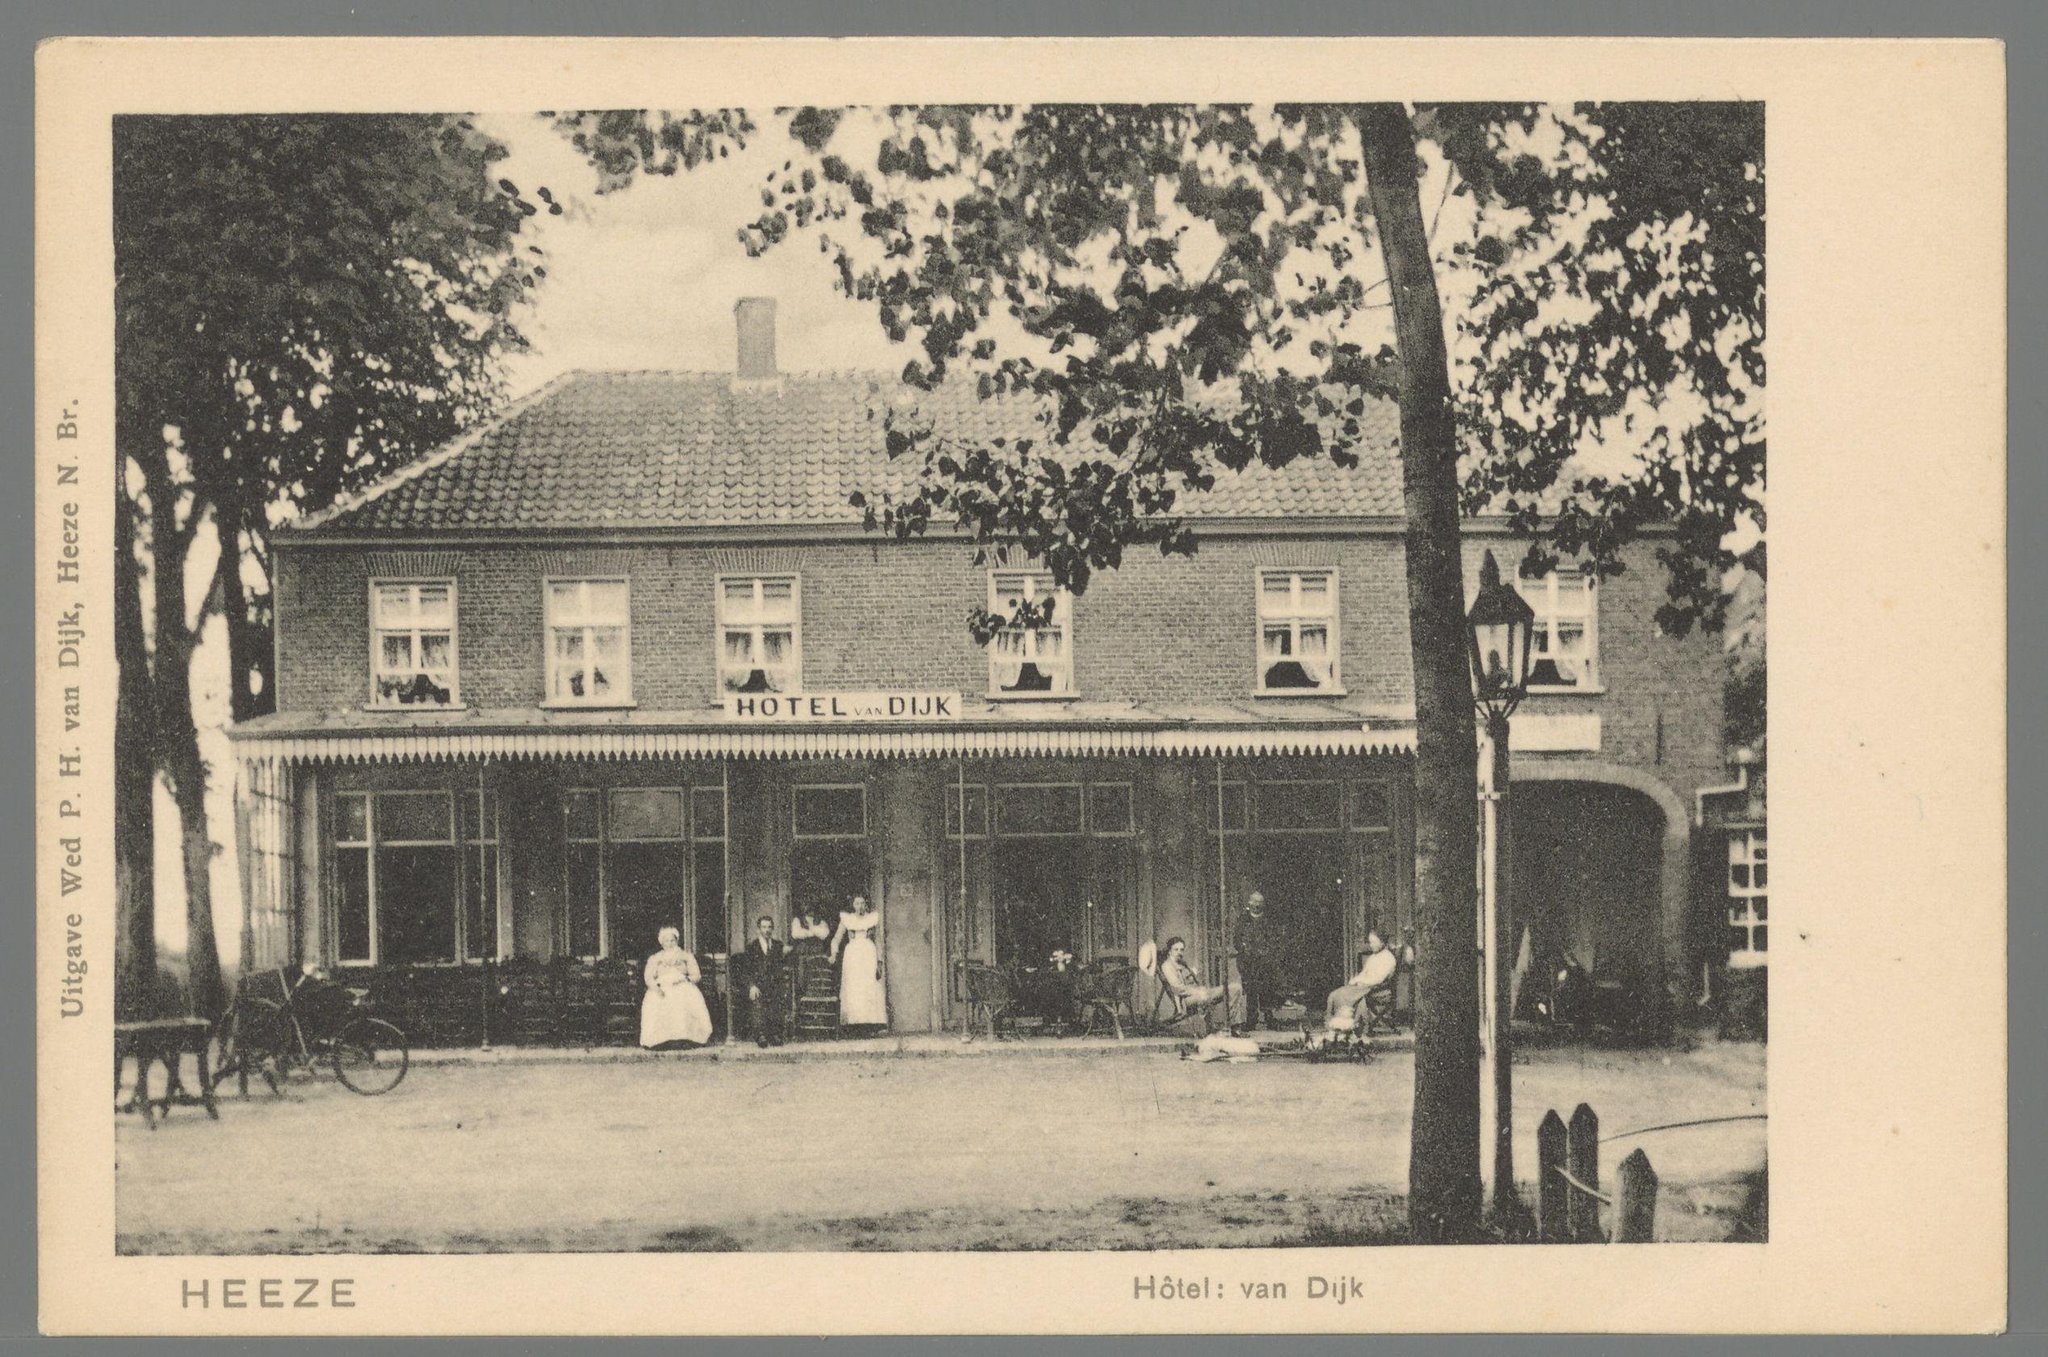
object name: photomechanical print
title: Heeze. Hôtel: van Dijk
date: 1892-1905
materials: cardboard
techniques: photograph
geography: heeze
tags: hotel, hostelry, inn